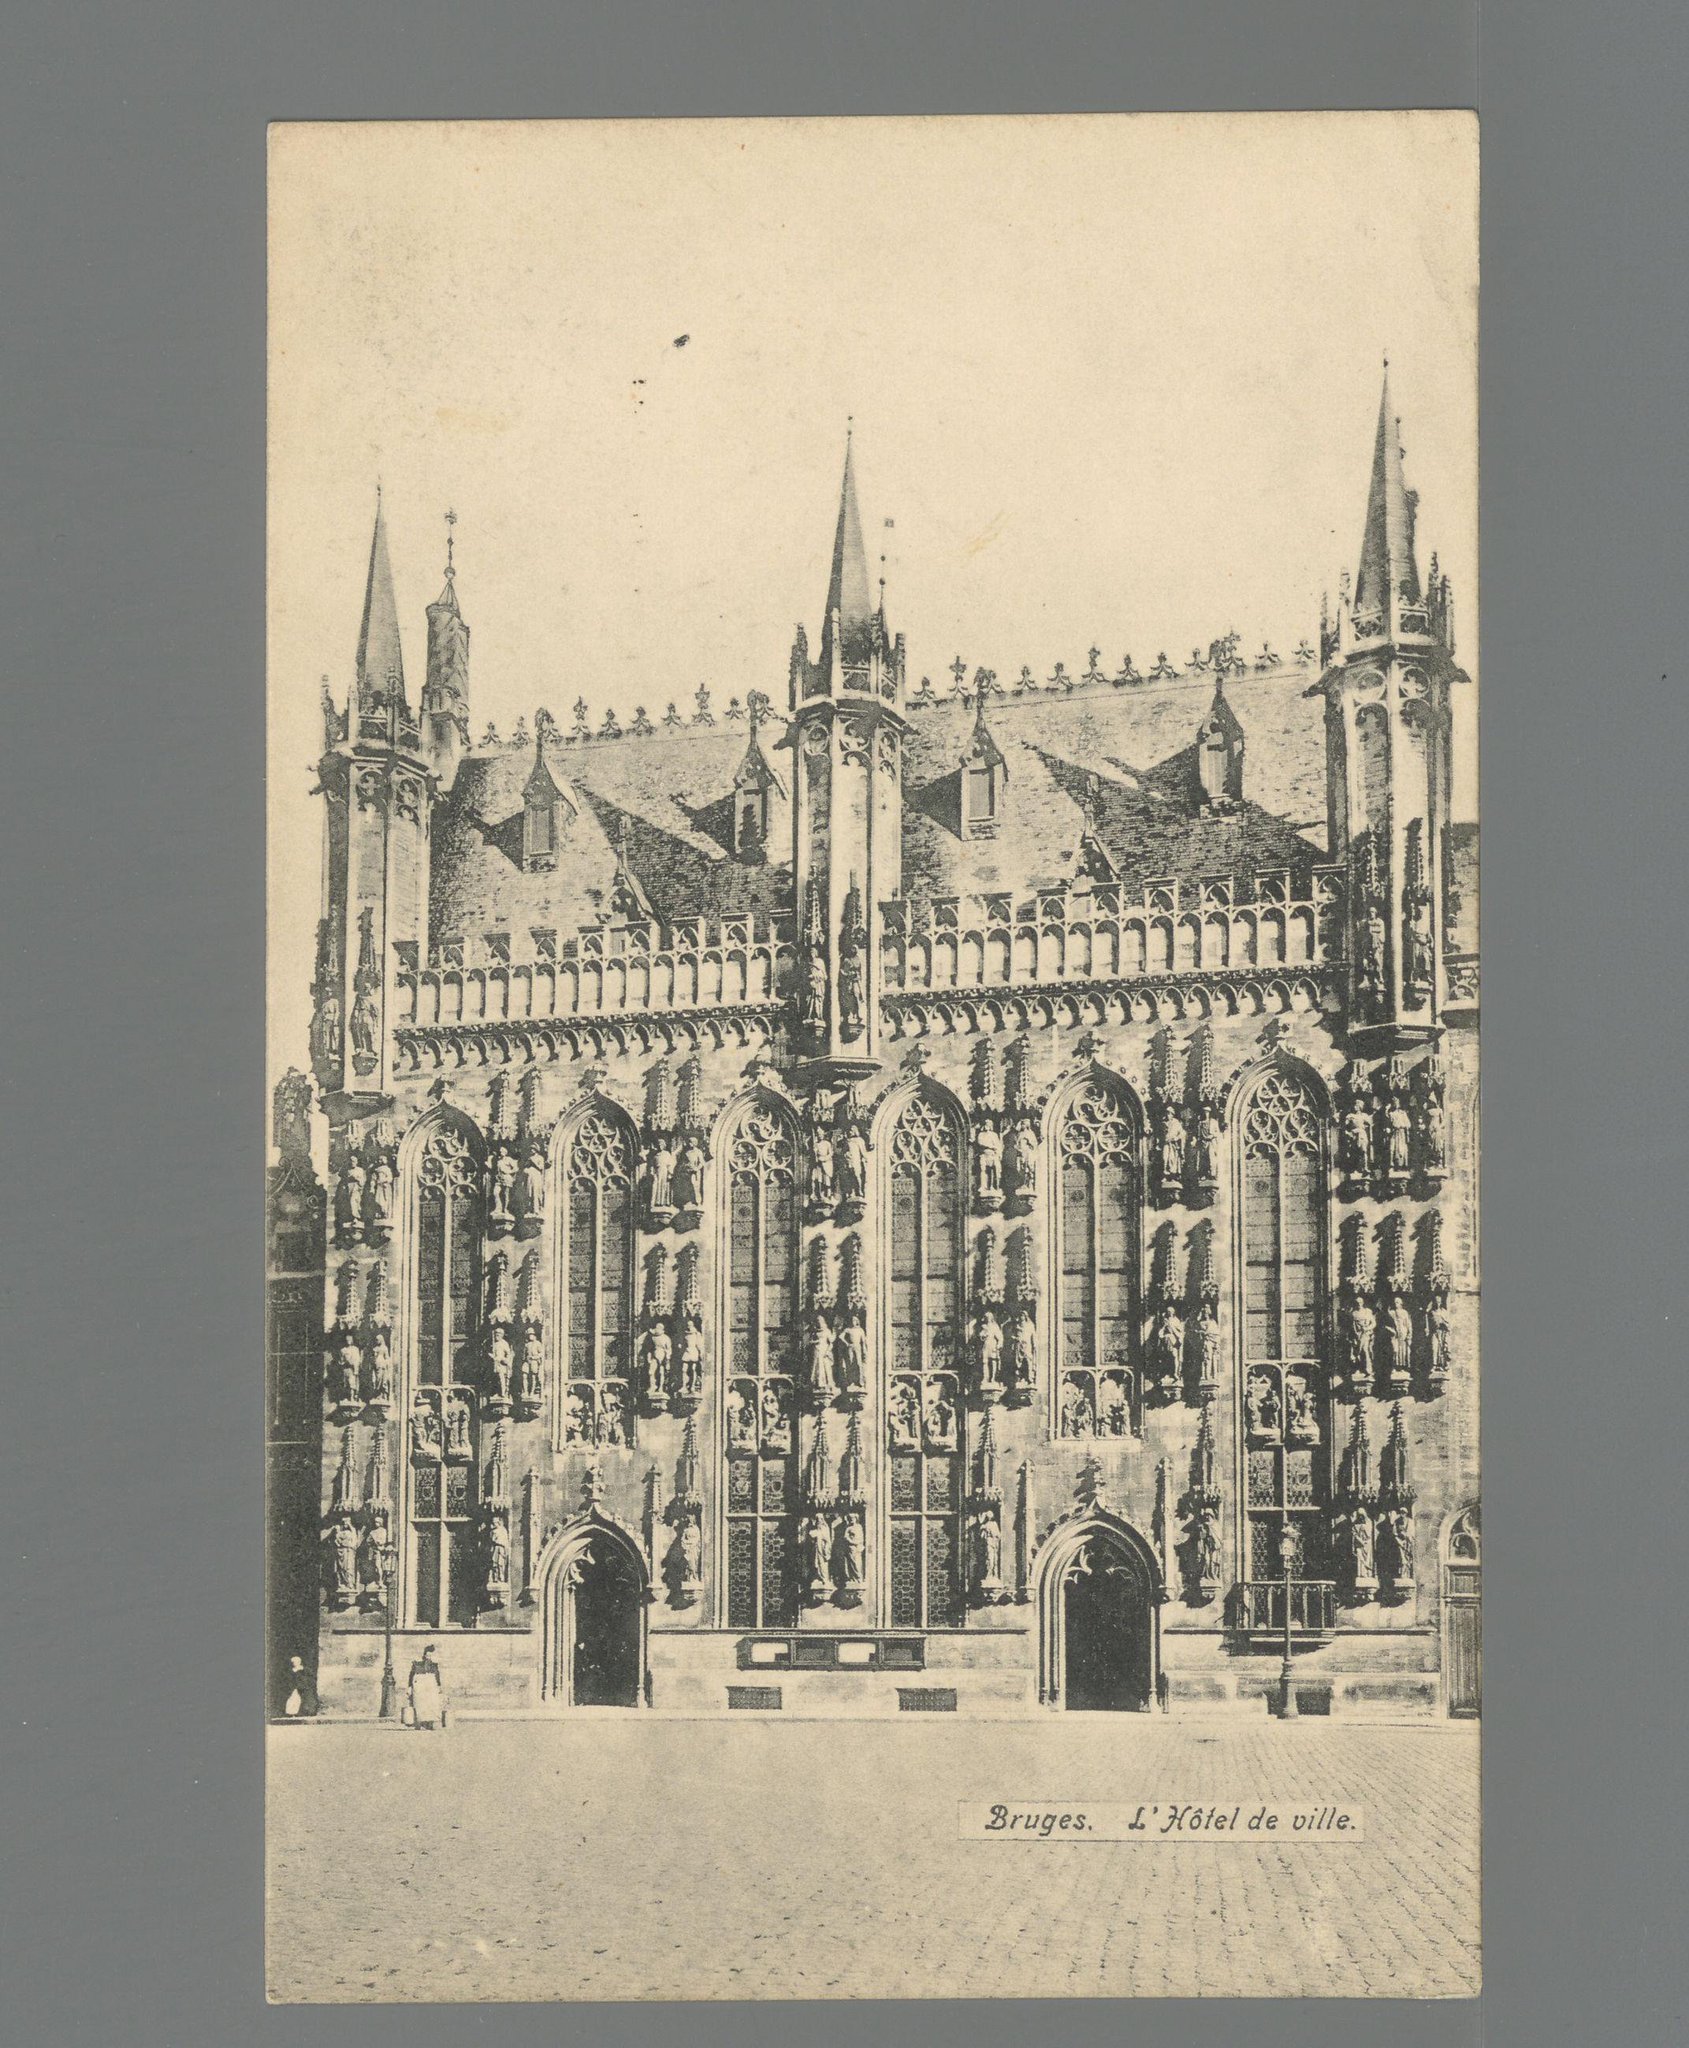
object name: photomechanical print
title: Bruges. L'Hôtel de ville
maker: Anonymous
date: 1906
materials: cardboard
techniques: photograph, writing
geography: bruges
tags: square, place, circus, etc., townhall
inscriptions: postage stamp